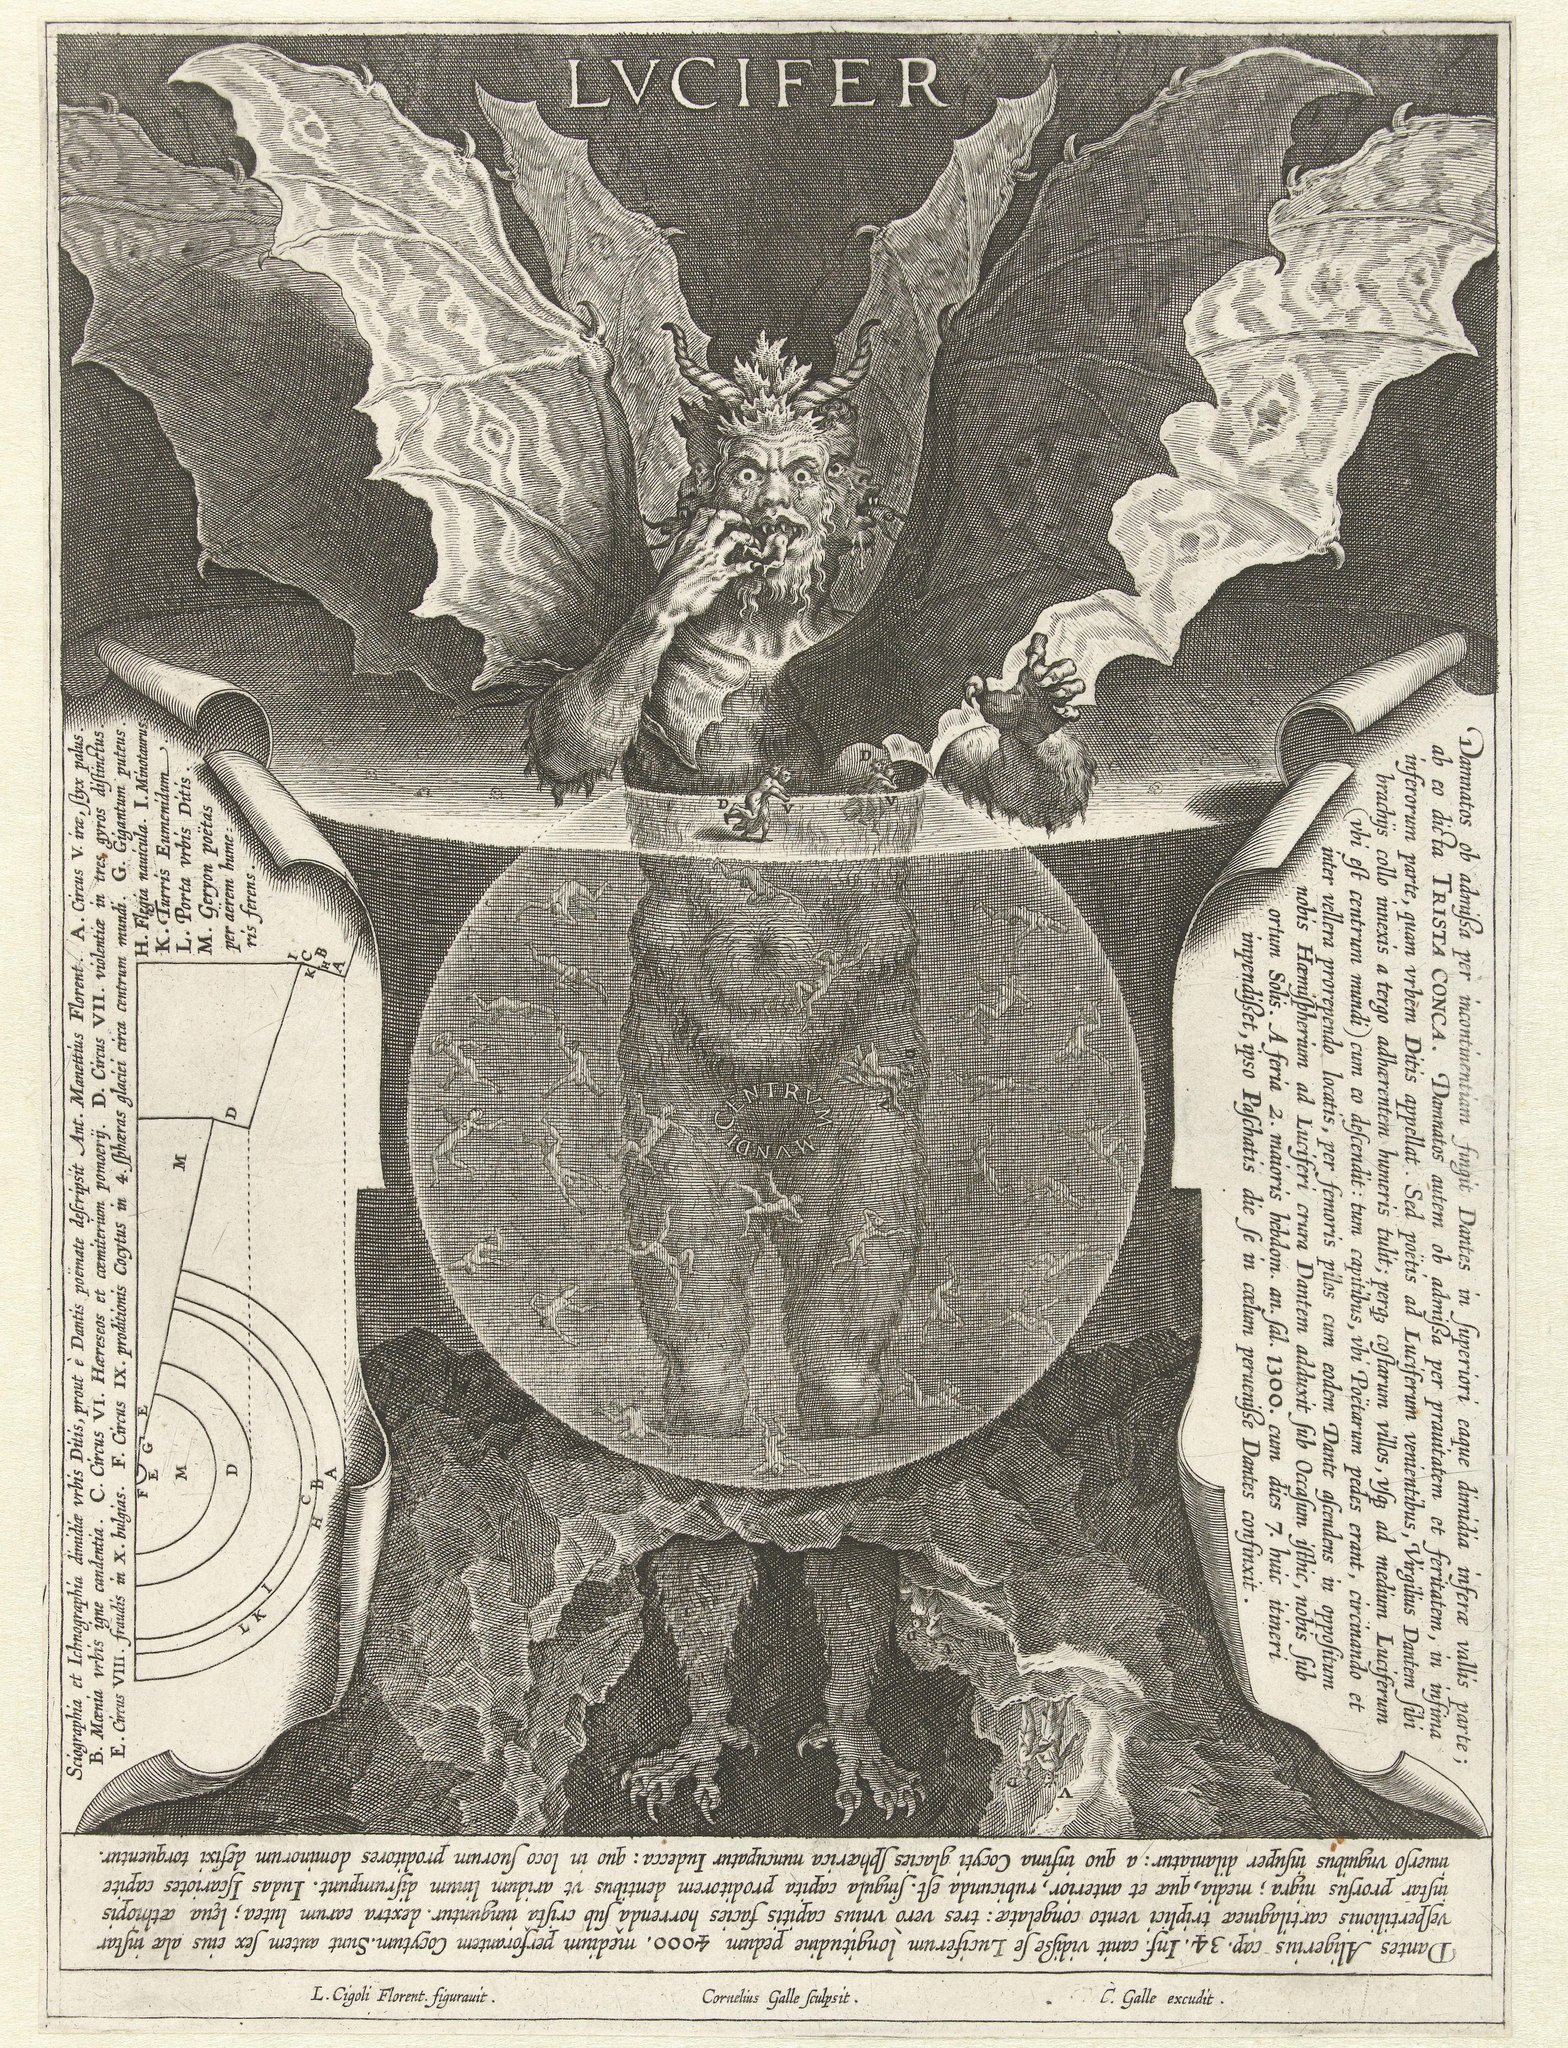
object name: print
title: Lucifer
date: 1590-1600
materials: paper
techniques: engraving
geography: italy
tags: (scenes from) specific works of literature: dante, divina commedia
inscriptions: collector's mark: Lugt 2760, collector's mark: Lugt 2228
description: Een driekoppige duivel met zes vleugels staat met zijn voeten in een grot en tot zijn borst in een bol waarin mensen drijven. Illustratie voor Dante Alighieri's Divina Comedia. Twee figuren, gekenmerkt met D en V (Dante en Virgilius) inspecteren de duivel op verschillende plaatsen. Ze kijken naar zijn drie koppen, dalen af door de bol en bekijken in de grot zijn voeten. Aan weerszijden en onder verklarende tekst in het Latijn.